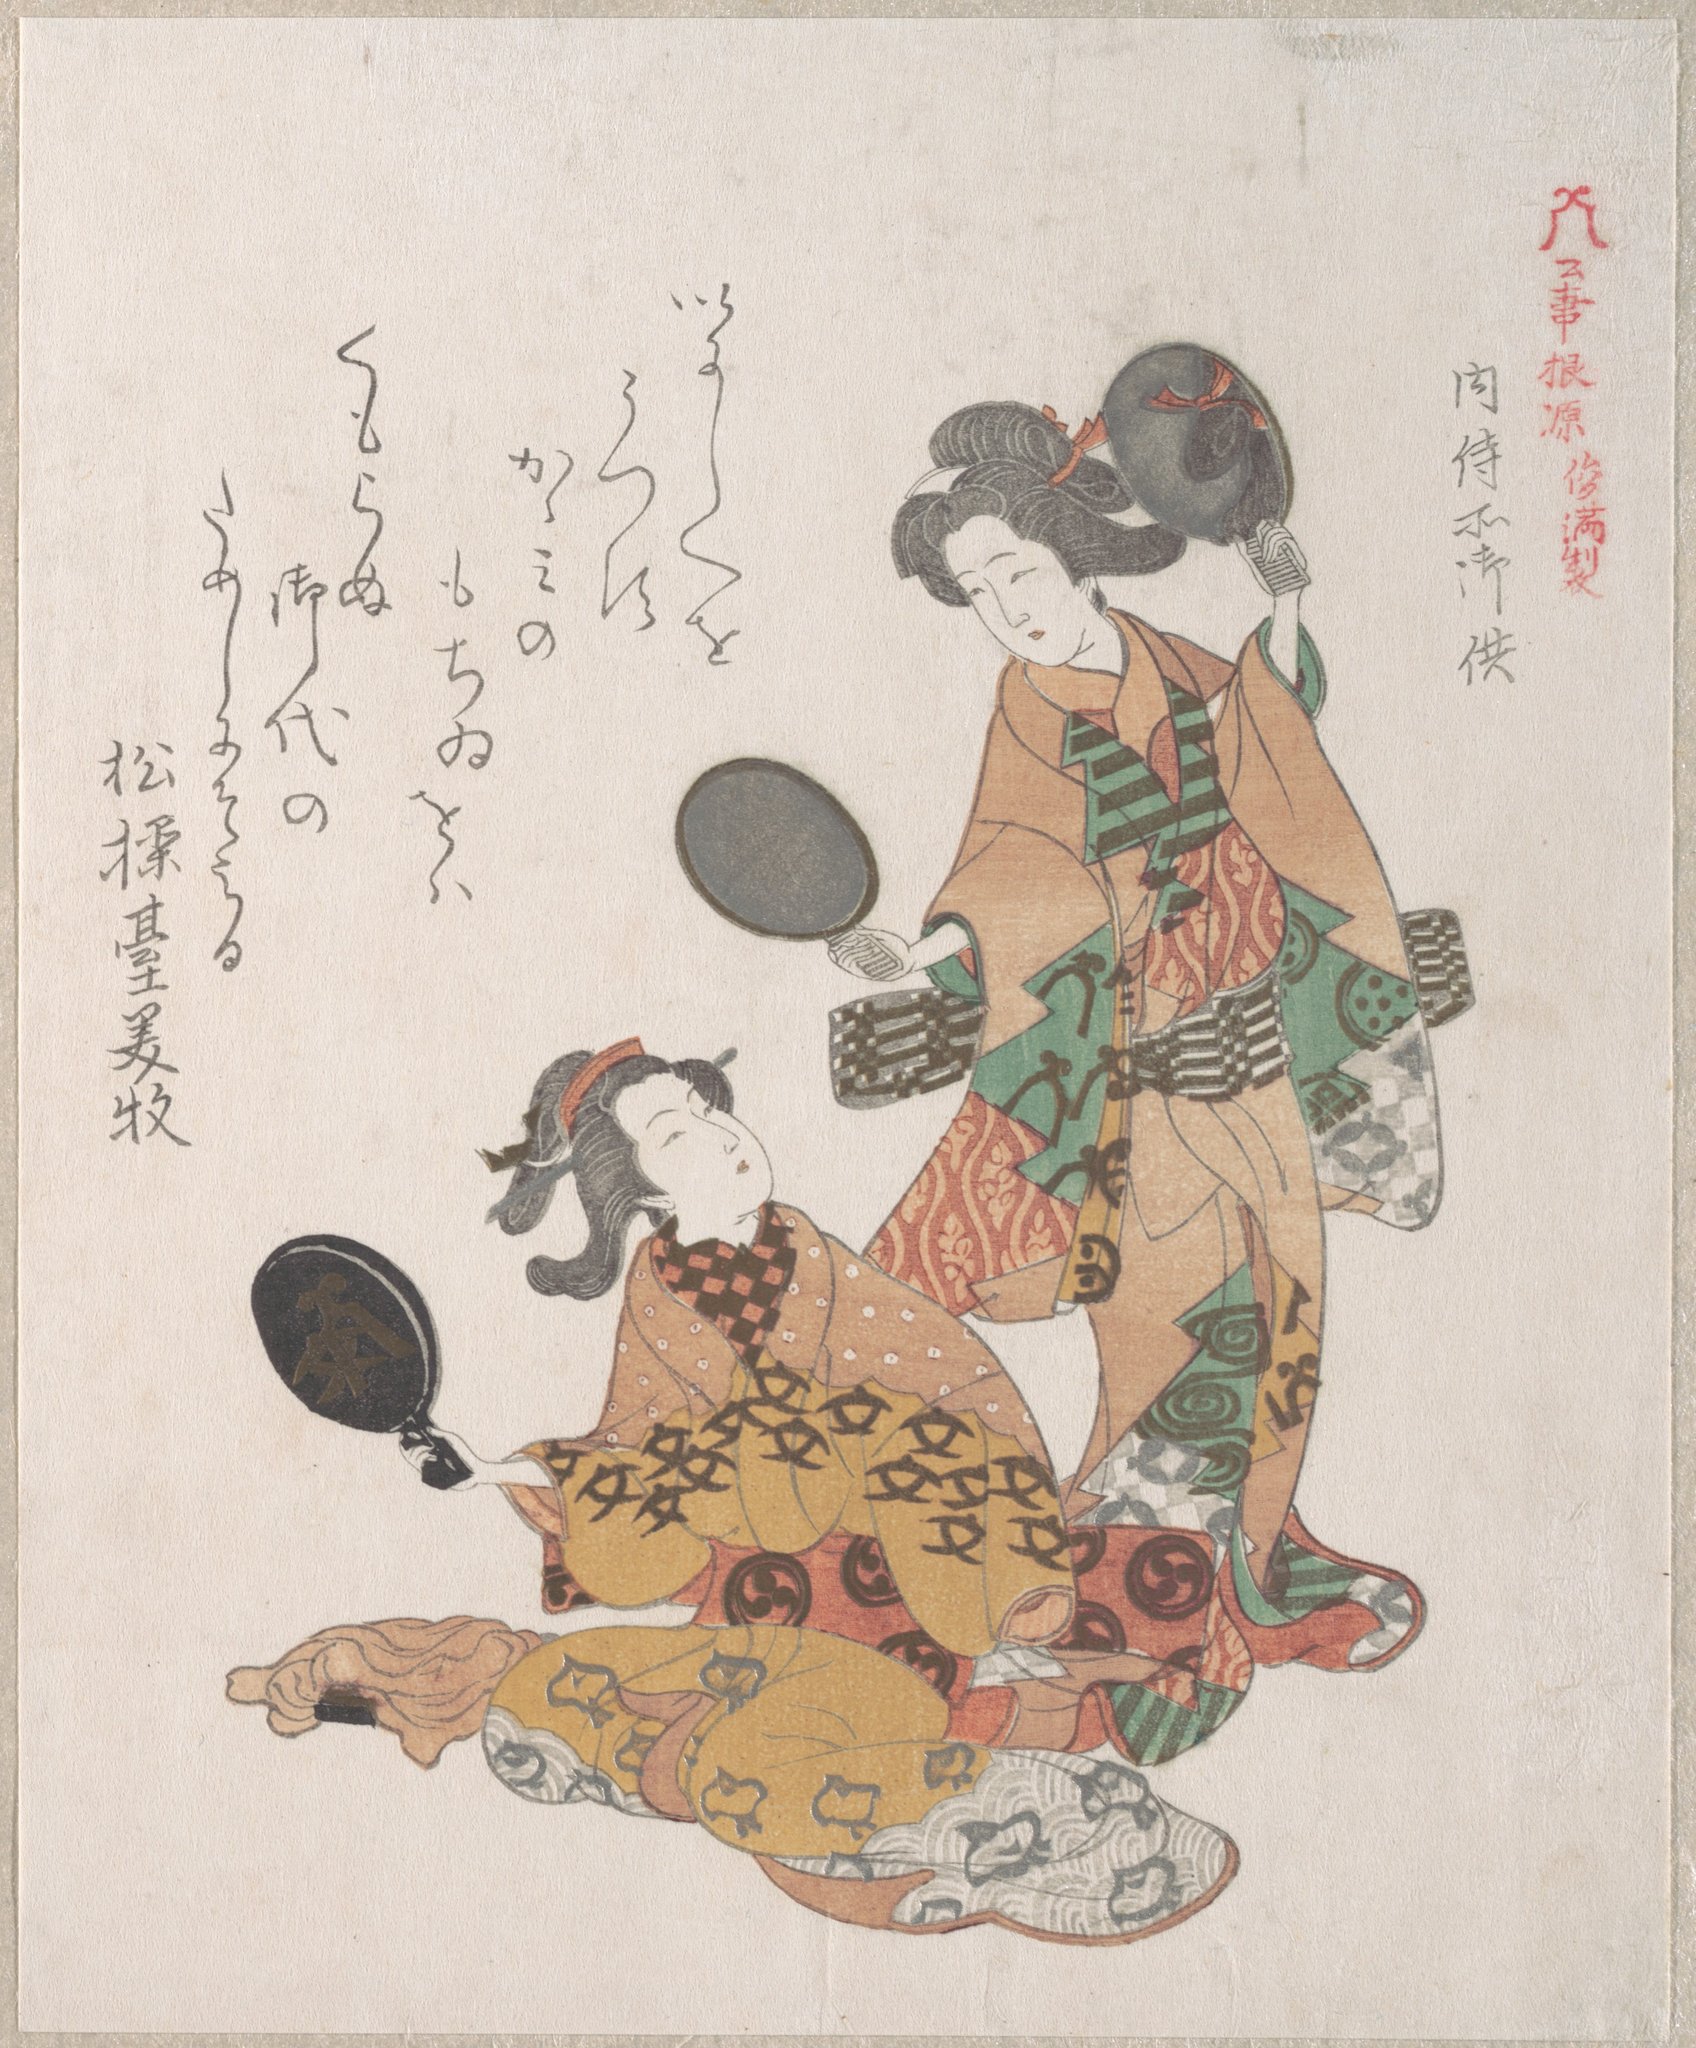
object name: print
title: Two Women Looking in Mirrors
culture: japanese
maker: kubo shunman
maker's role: artist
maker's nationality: japanese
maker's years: 1757-1820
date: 1801-1900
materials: ink, paper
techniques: surimono, woodblock print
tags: women,mirrors